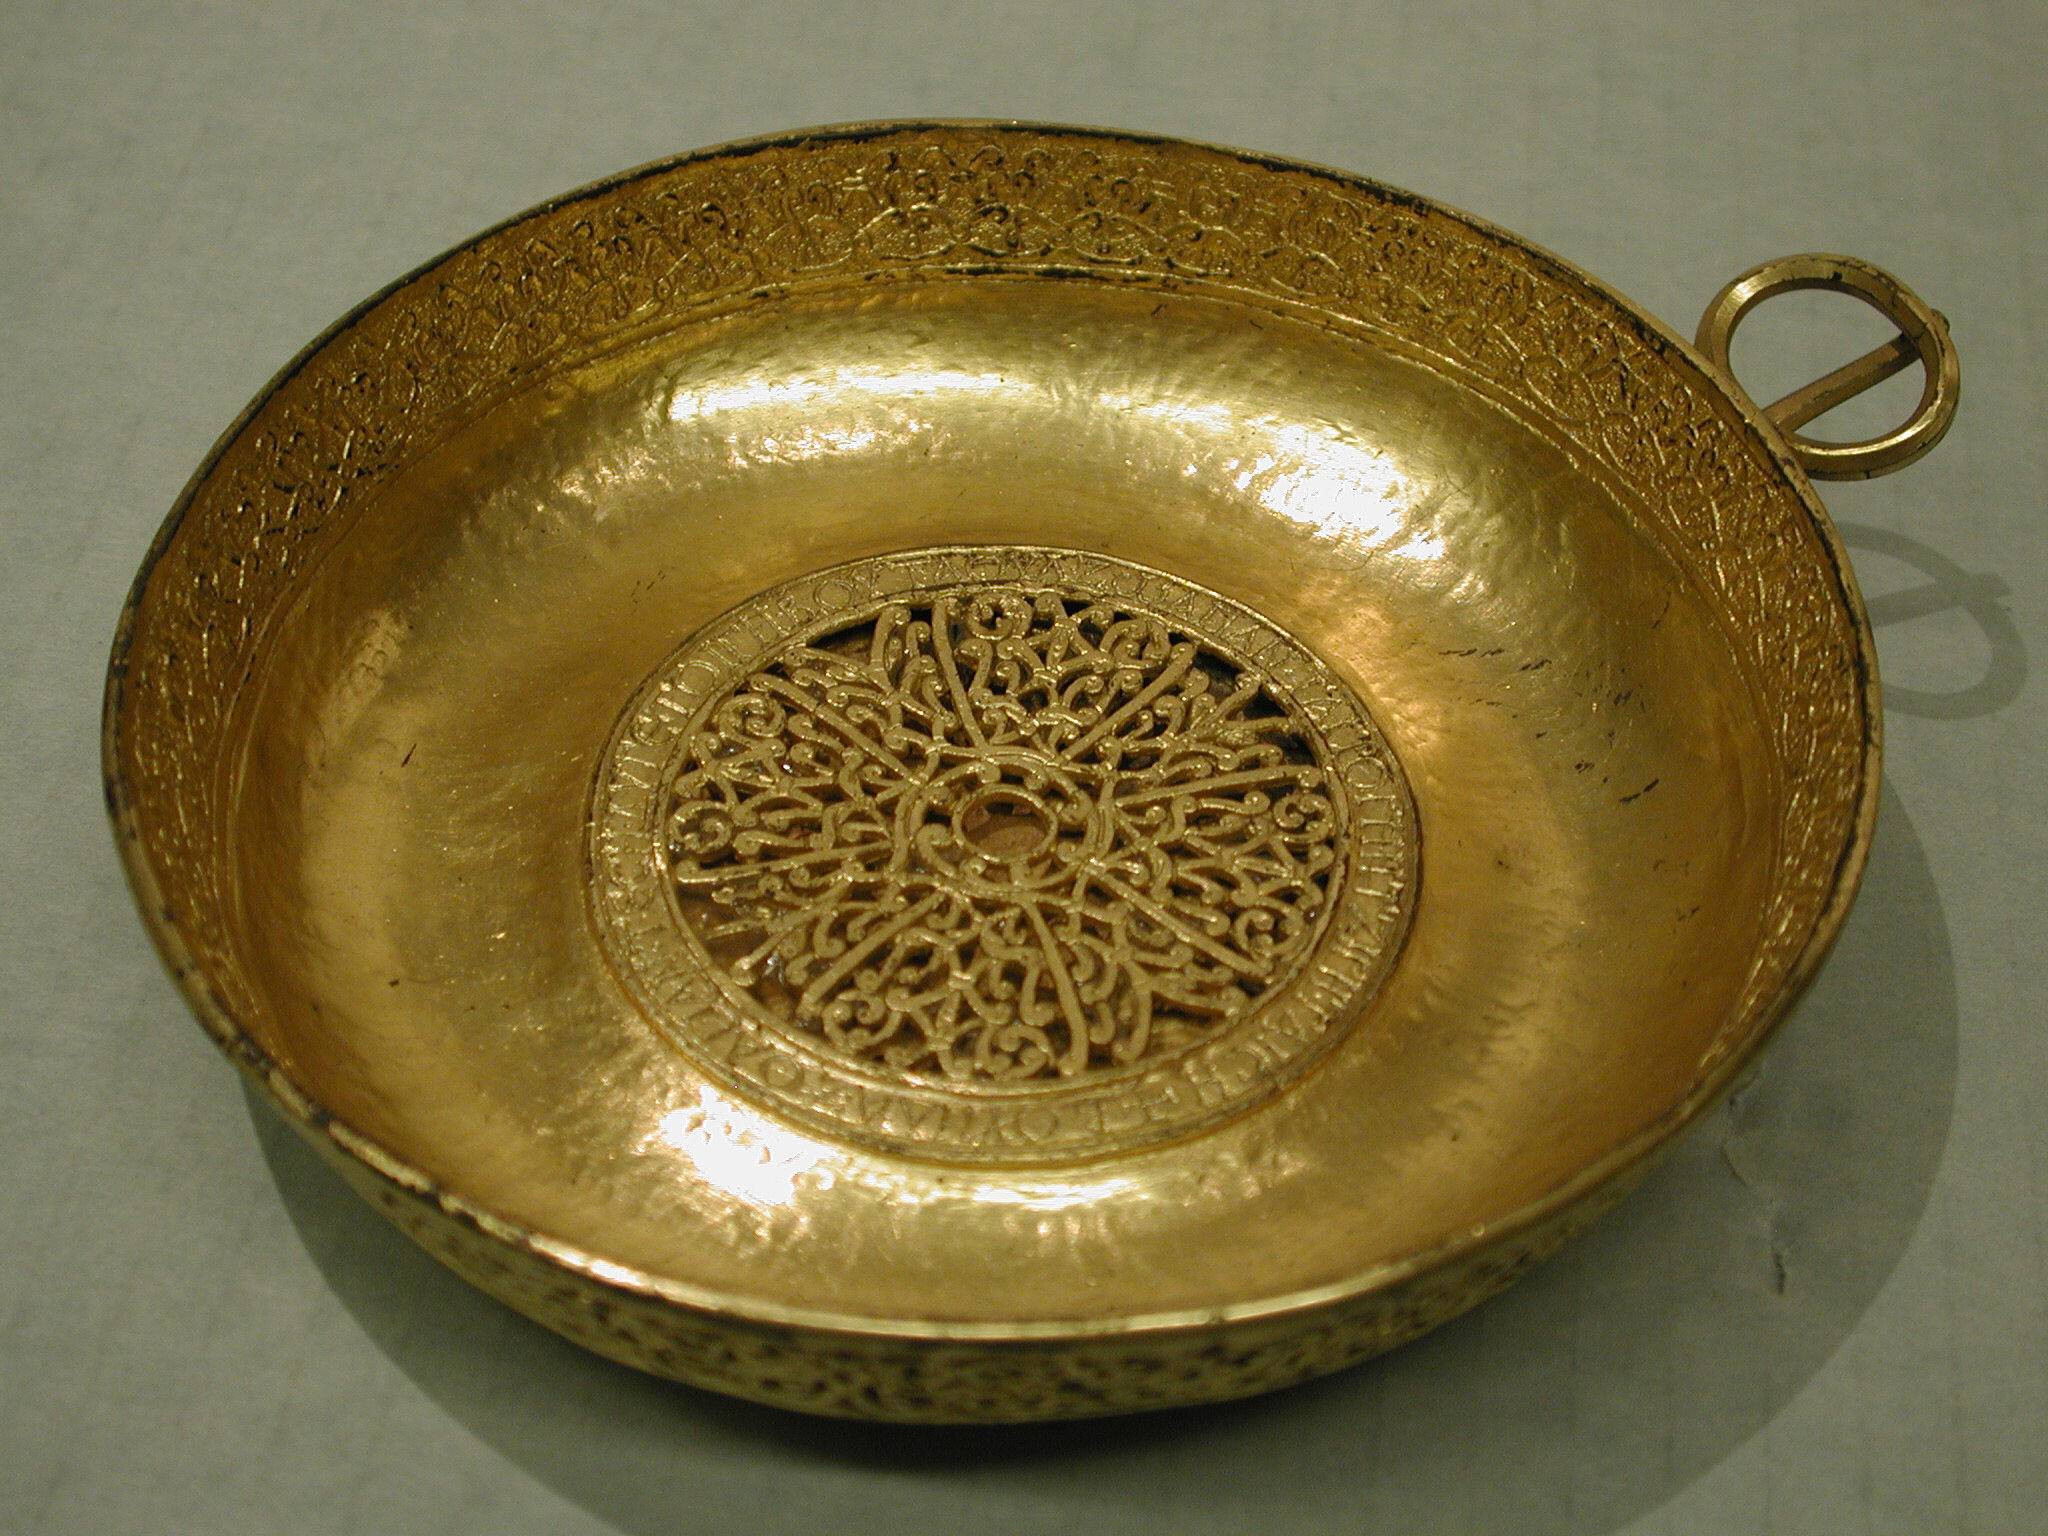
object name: bowl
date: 1801-1900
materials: metal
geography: hungary